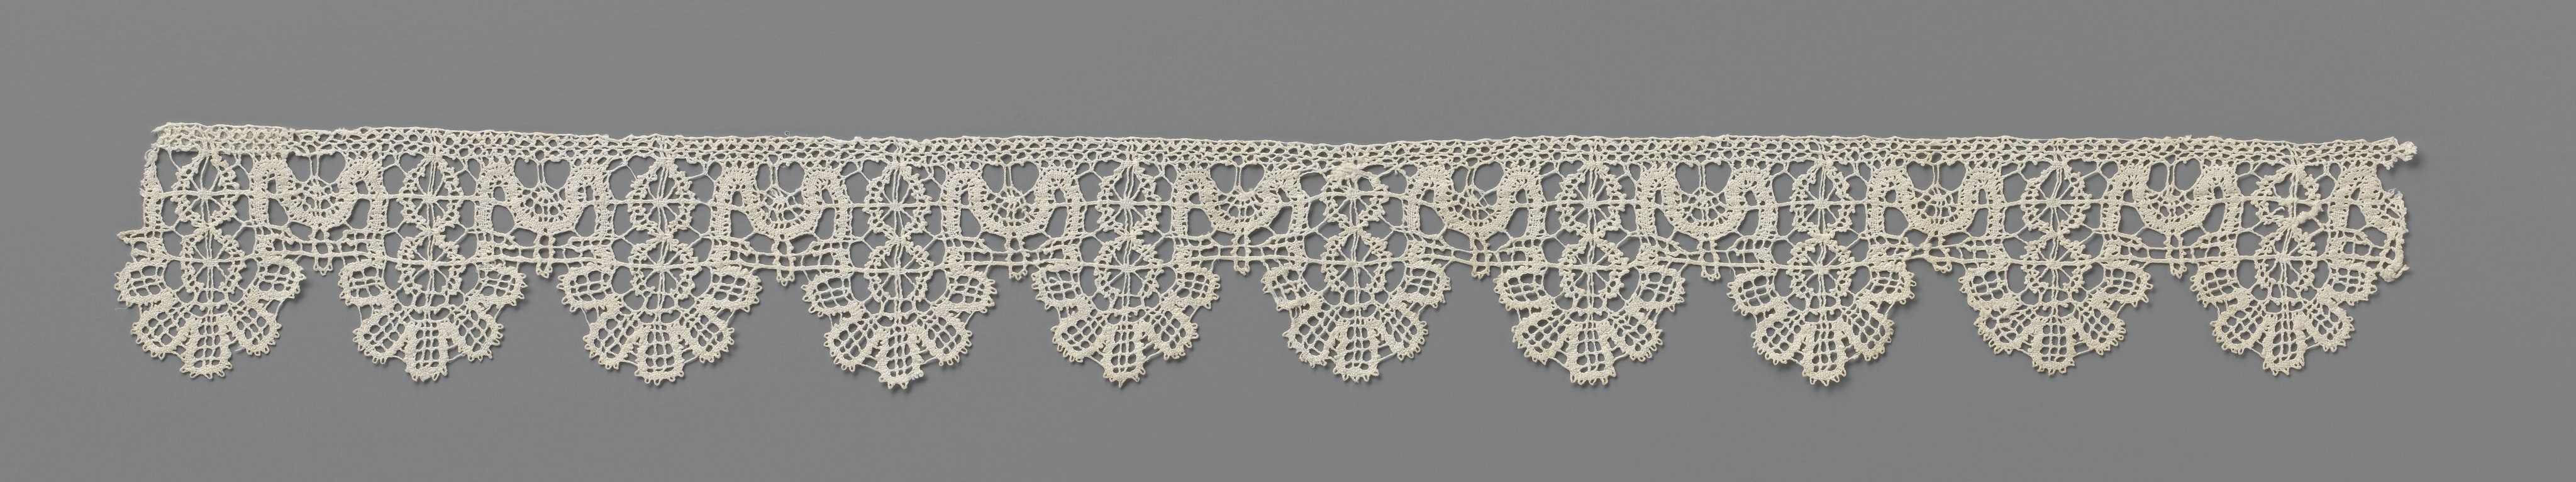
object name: strip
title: Strook kloskant met wielen en vijflobbige schulpen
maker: Anonymous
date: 1620-1630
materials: linen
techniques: lace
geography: southern netherlands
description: Strook naturelkleurige kloskant: oudvlaamse kant. In de halfronde schulpen staat een zich repeterend en symmetrisch motief van twee boven elkaar geplaatste wielen, langs de onderkant omgeven door vijf lobben. Het patroon is opgebouwd uit een slingerend lint gemaakt in linnenslag, voornamelijk in vorm gehouden door vlechtjes.